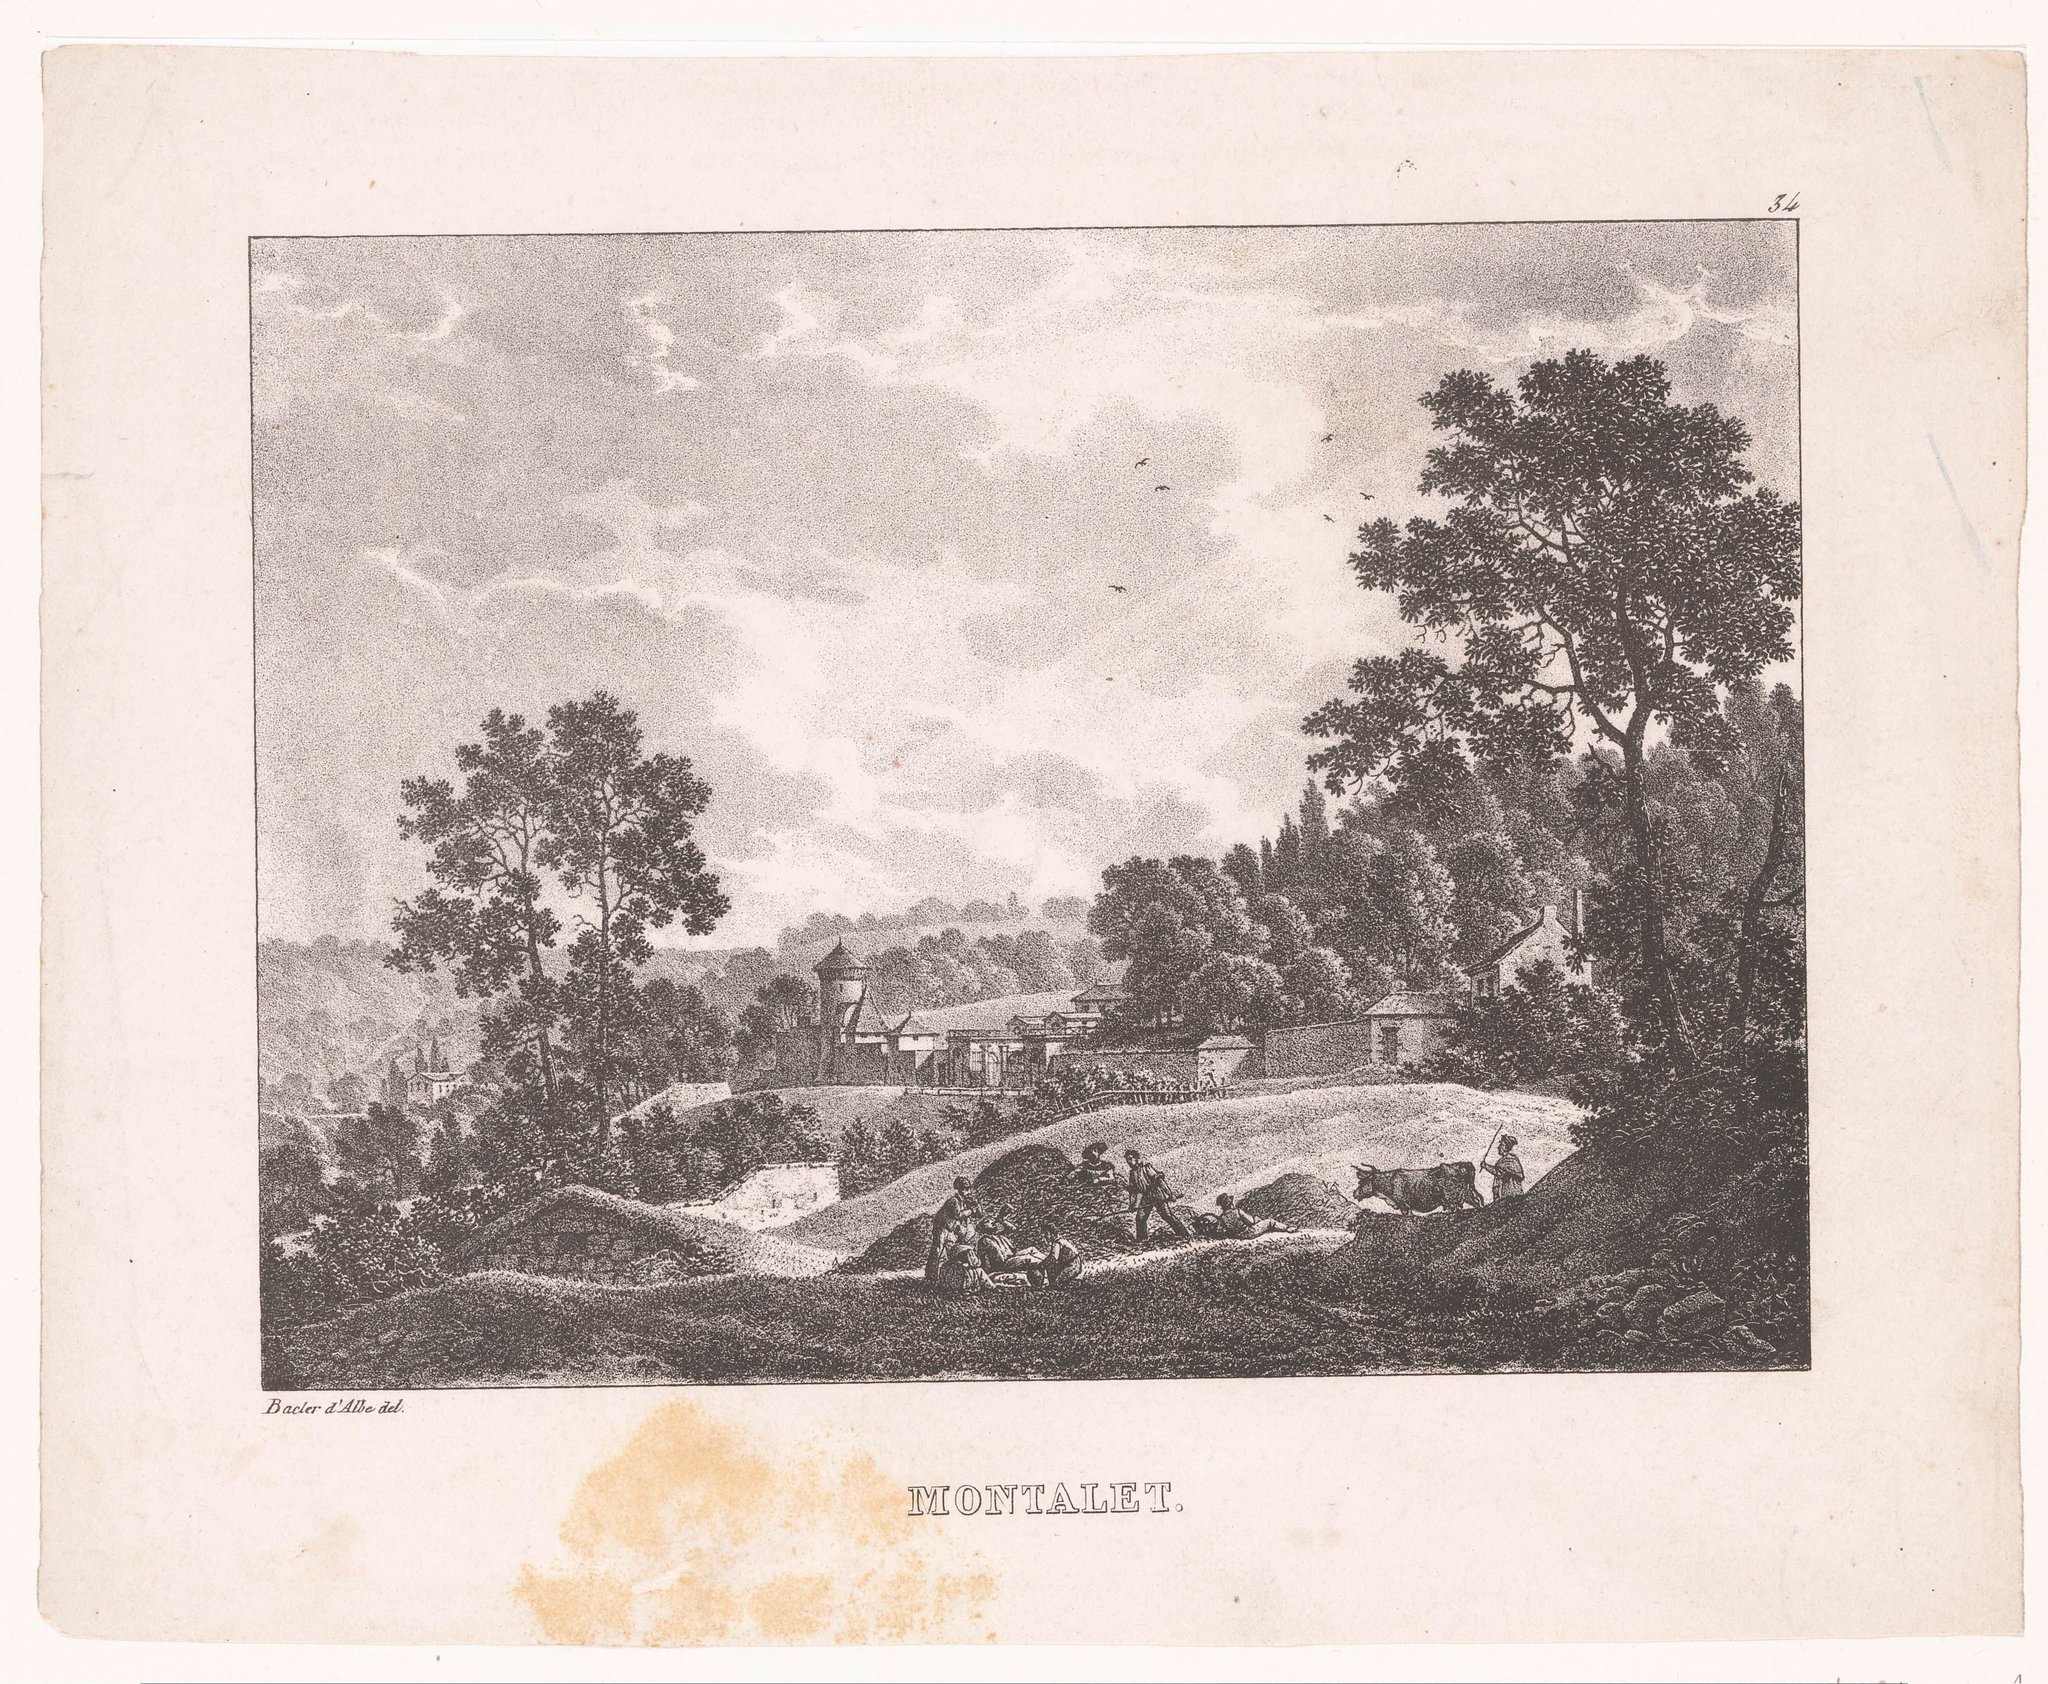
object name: print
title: Promenades pittoresques et lithographiques dans Paris et ses environs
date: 1822-1824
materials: paper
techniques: lithograph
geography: paris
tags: pleasure-resort, farmers, landscape with tower or castle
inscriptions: collector's mark: Lugt 2228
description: Op de voorgrond zijn boeren aan het hooien en rusten.